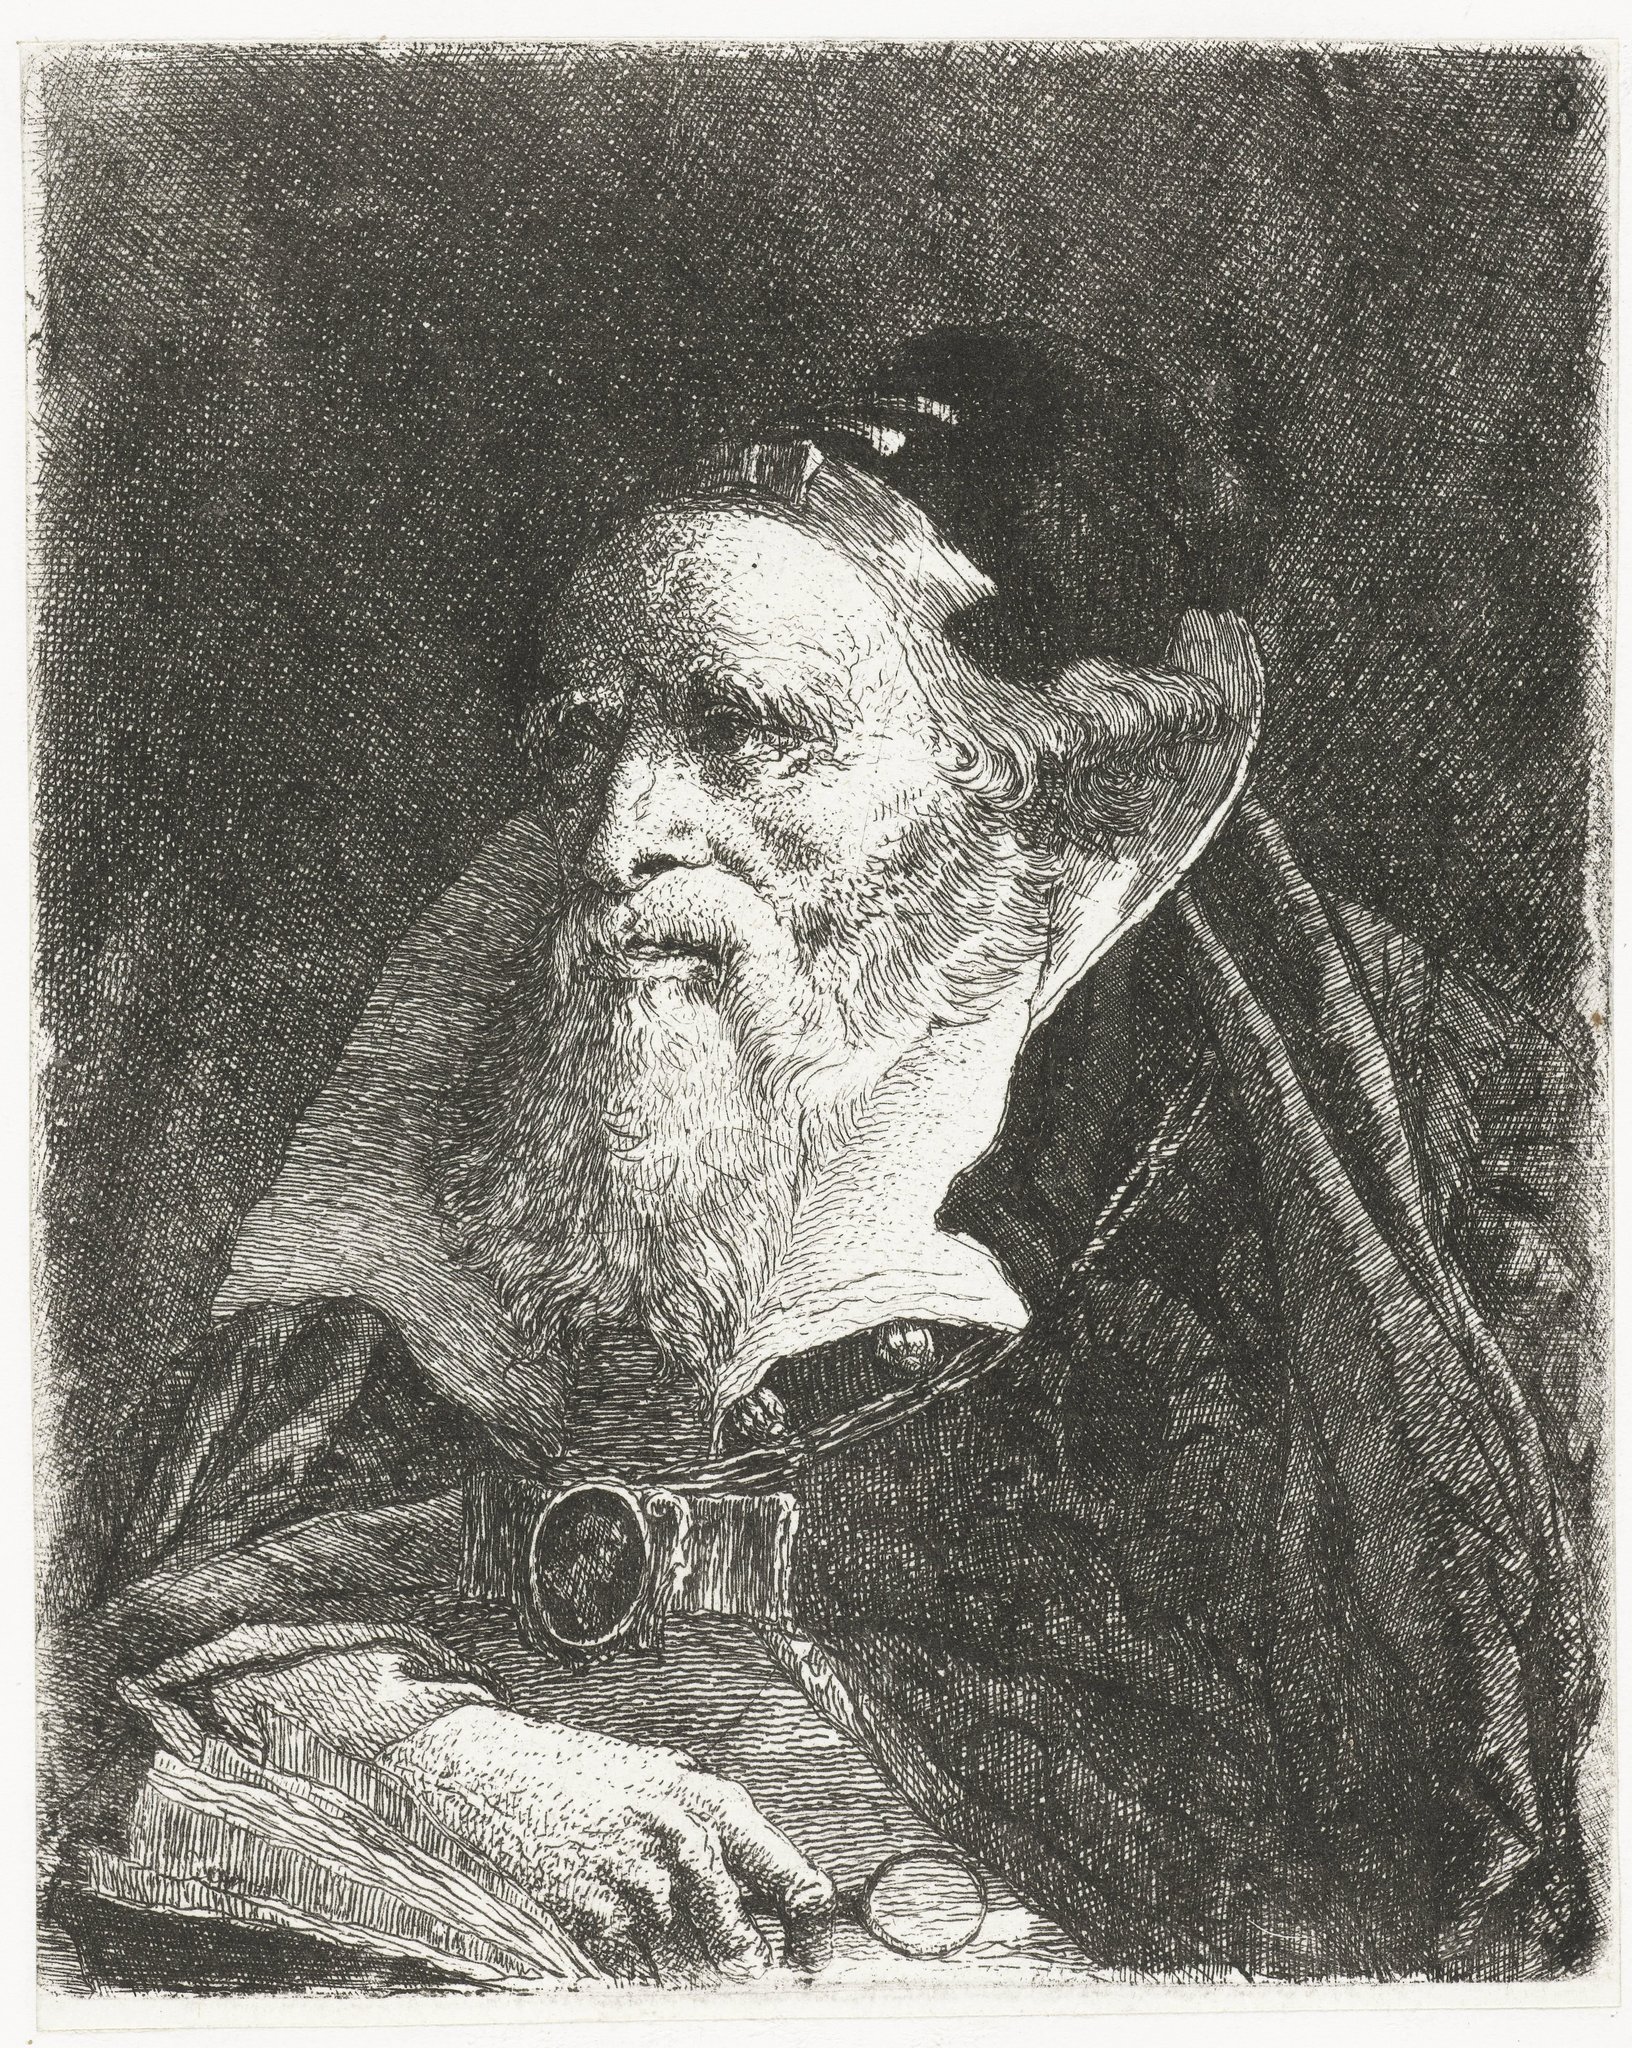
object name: print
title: Heilige Hieronymus Aemilianus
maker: giovanni domenico tiepolo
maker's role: draughtsman, print maker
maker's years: 1727-1804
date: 1740-1744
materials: paper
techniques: etching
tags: saints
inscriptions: collector's mark: Lugt 2760, collector's mark: Lugt 2228